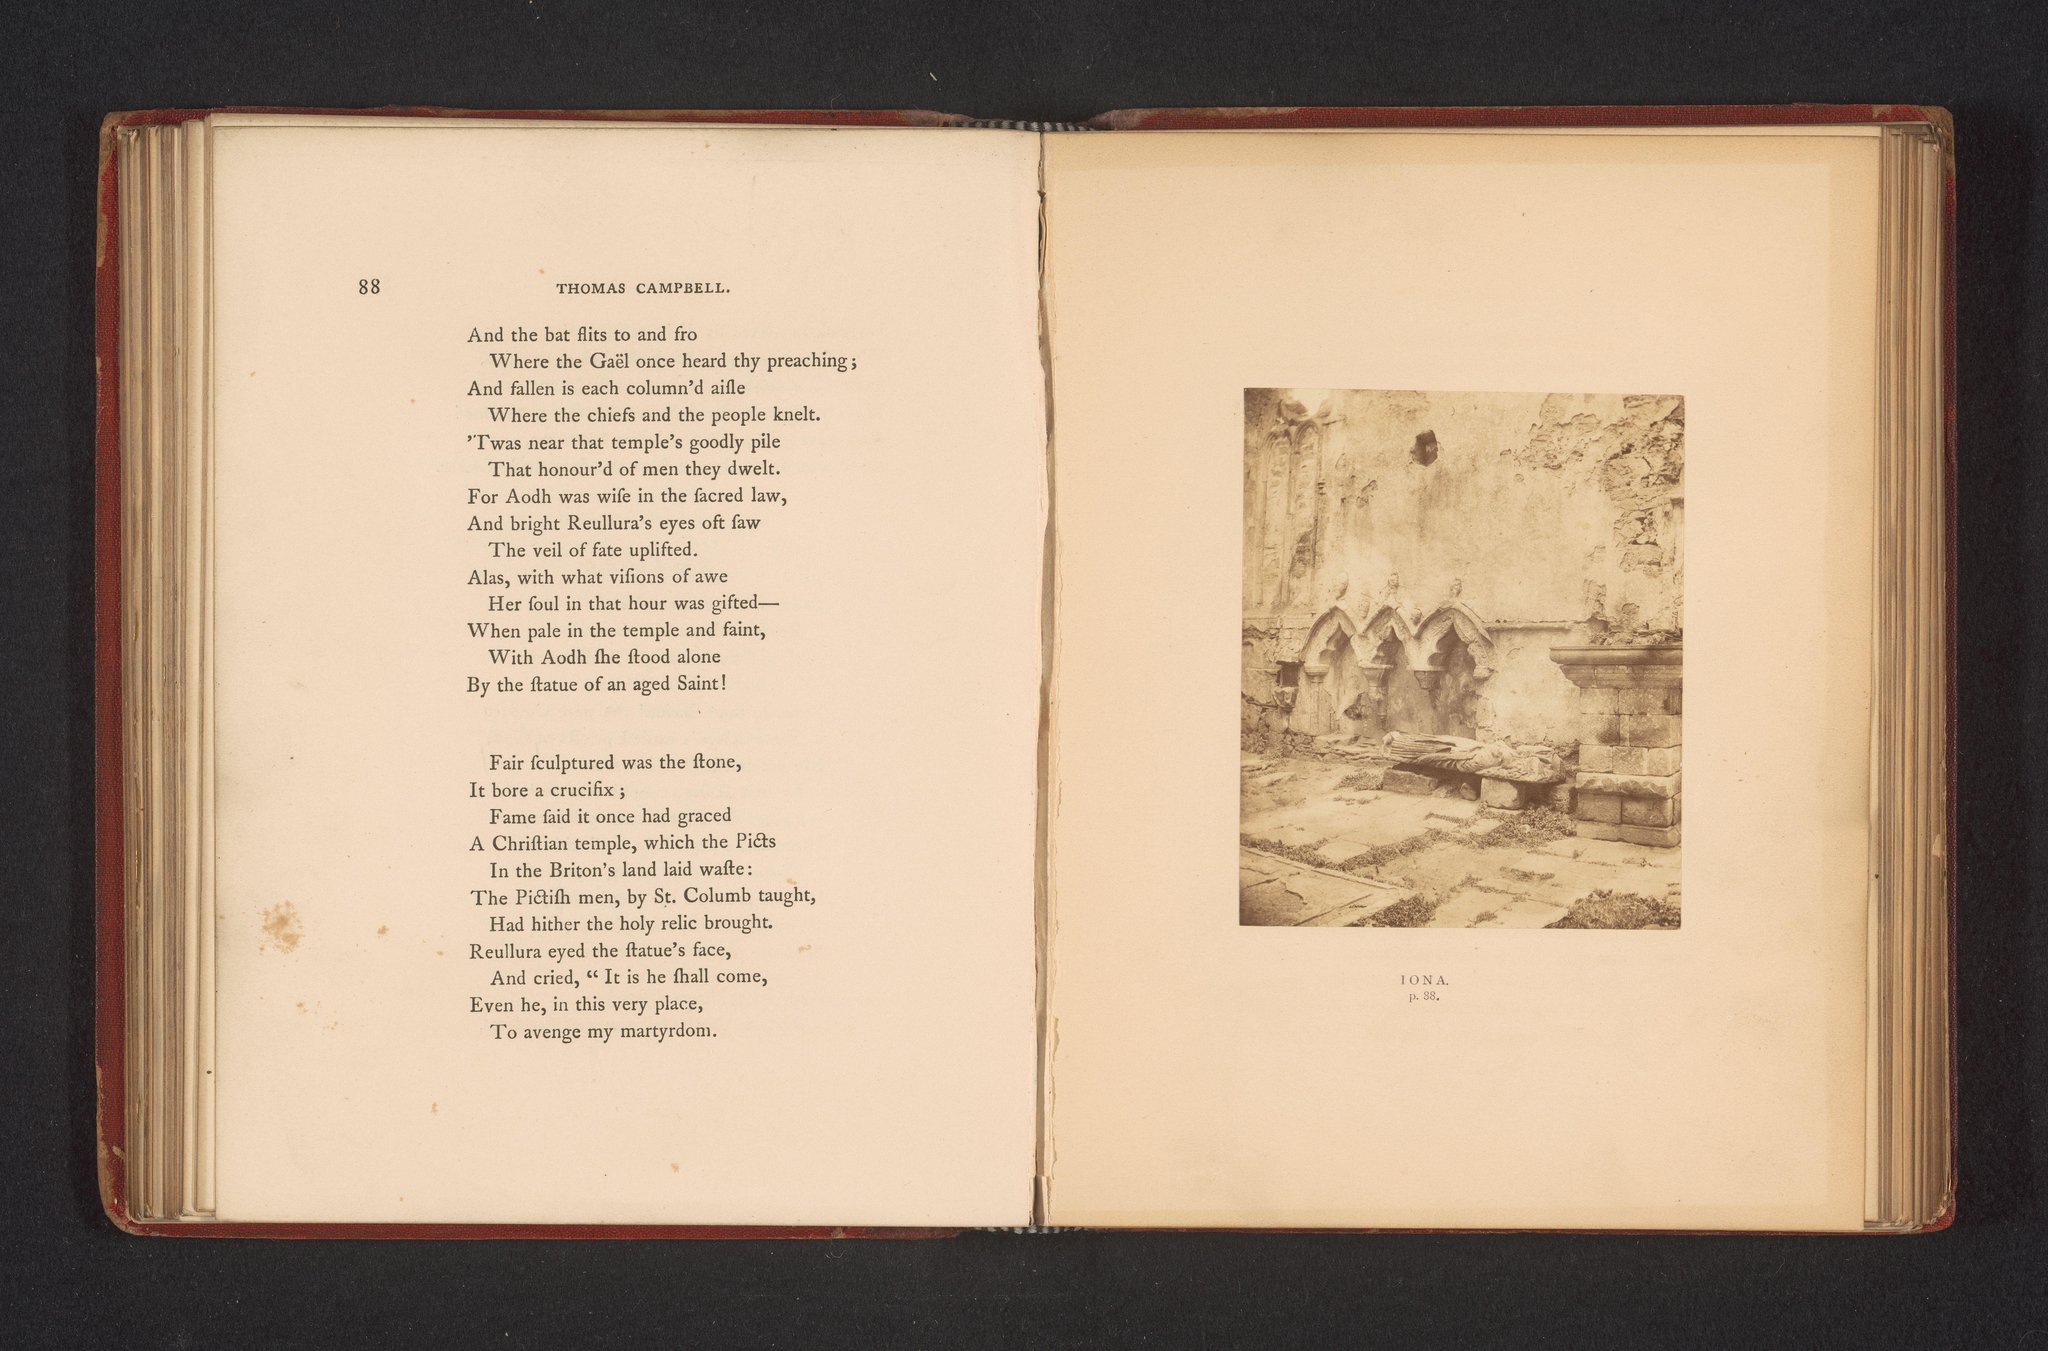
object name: photograph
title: Iona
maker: stephen thompson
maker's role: fotograaf, schrijver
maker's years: 1831-1893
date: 1863-1868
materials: photographic support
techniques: albumen print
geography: iona abbey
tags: ruin of church, monastery, etc., exterior ~ representation of a building